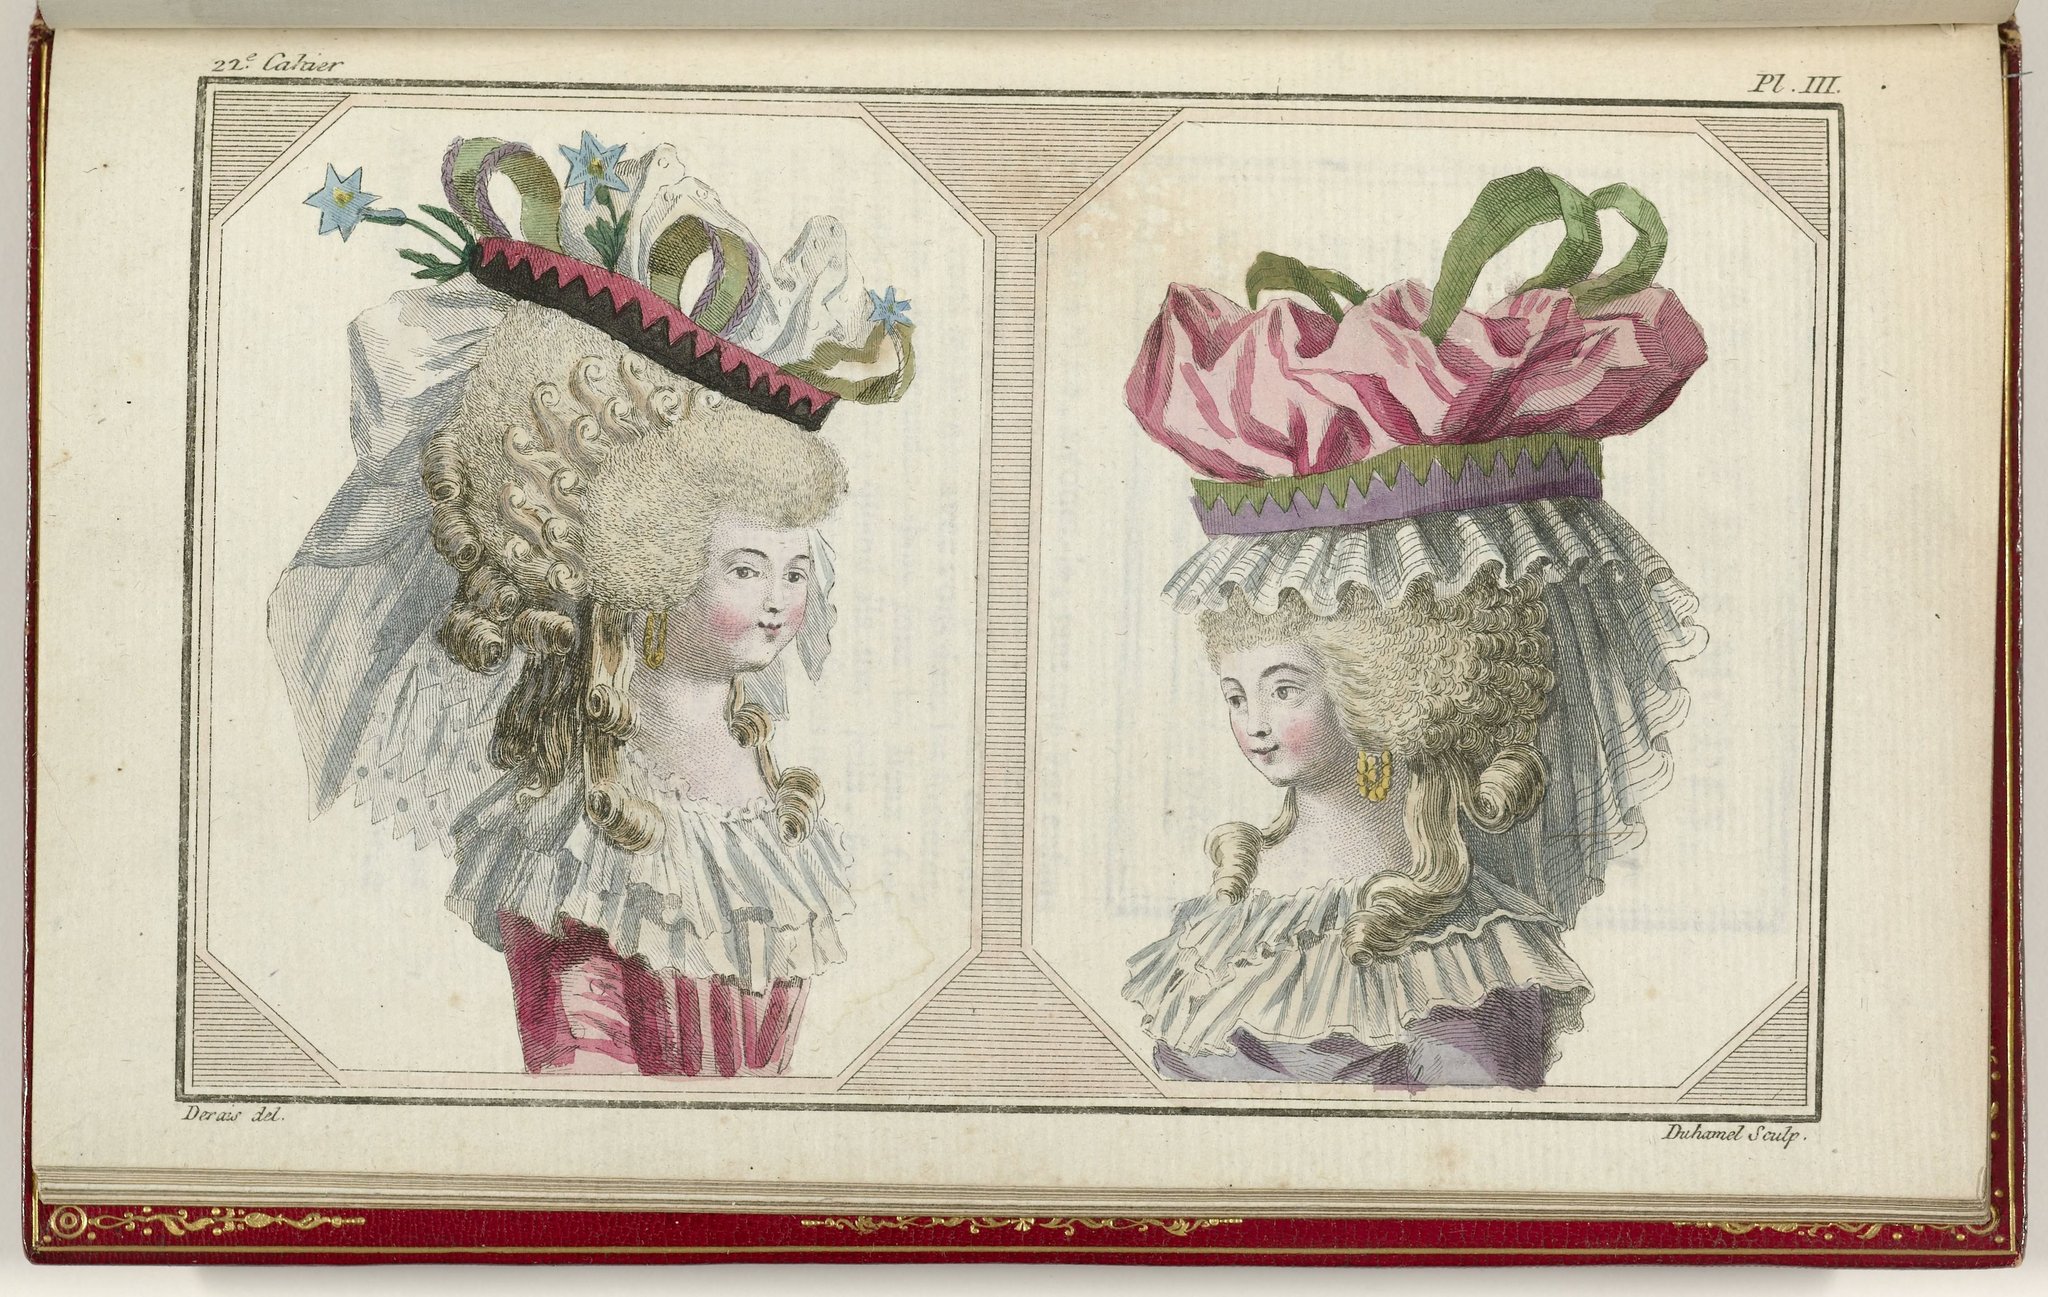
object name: fashion print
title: Cabinet des Modes ou les Modes Nouvelles, 1 Octobre 1786, pl. III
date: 1786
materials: paper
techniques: engraving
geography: paris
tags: styles of hairdress - aa - ~ women, head-gear: cap (+ women's clothes), fashion plates, piece of clothing covering the breast or décolleté (fichu) (+ women's clothes)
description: Twee vrouwenbustes: Links: Pouf à la Chinoise ; rechts: Toquet à la Virginie. Kapsels van Depain, hoeden van Roussaud